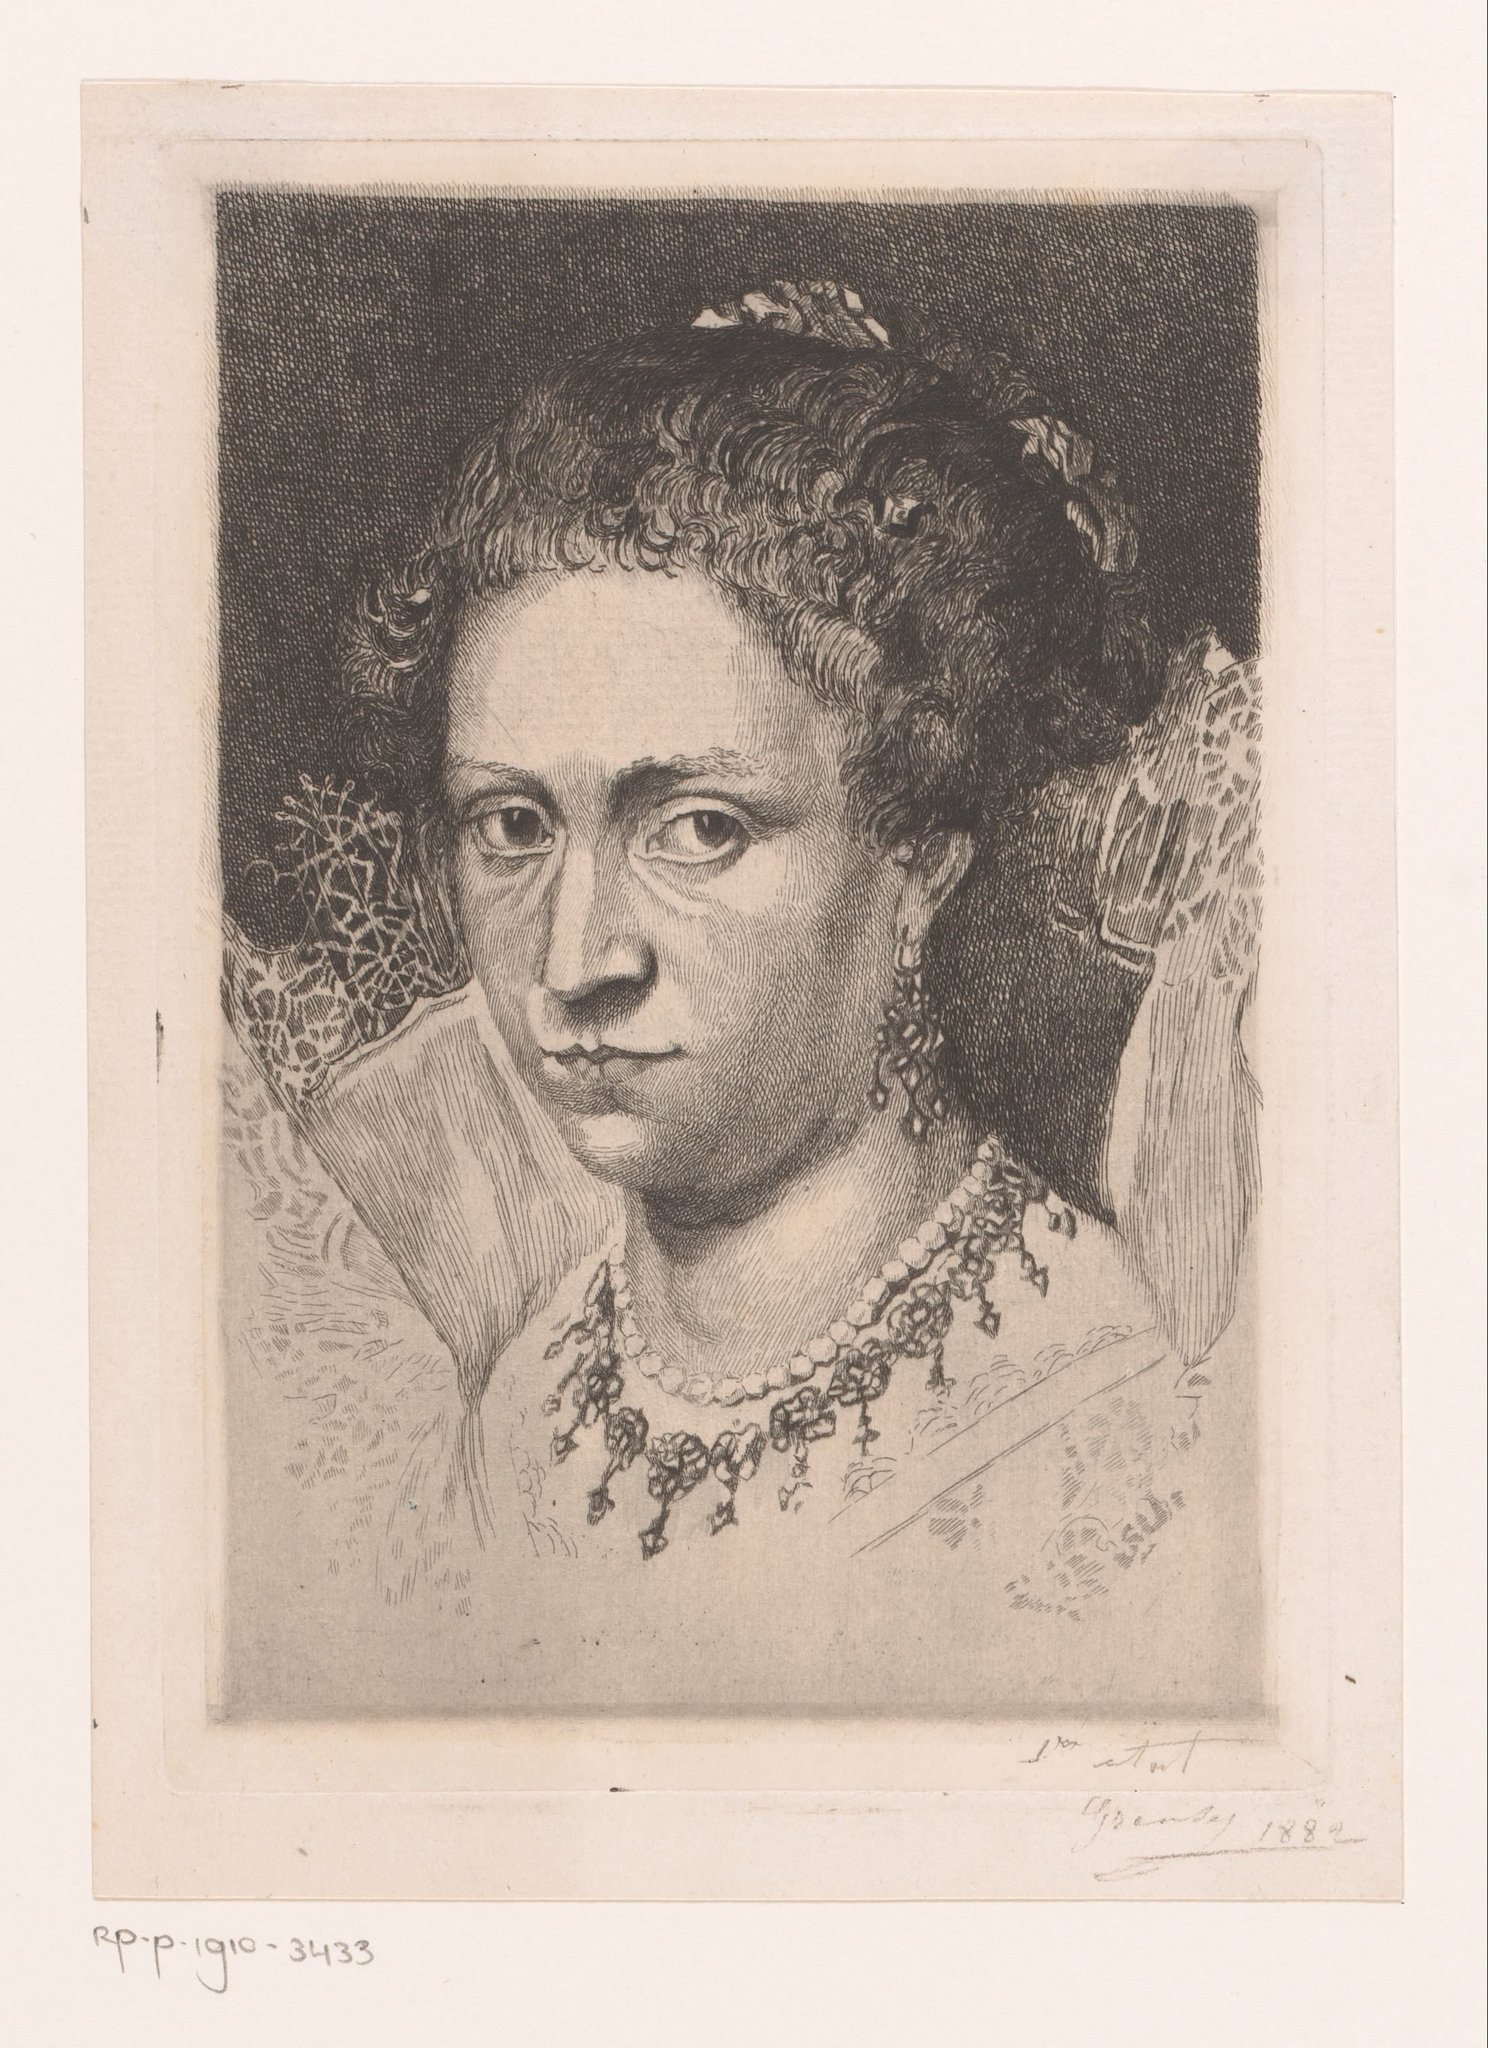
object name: print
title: Portret van Jacqueline de Caestre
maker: louis joseph greuse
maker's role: print maker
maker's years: 1863-1950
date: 1882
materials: paper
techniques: etching, intaglio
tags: historical persons - bb - woman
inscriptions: annotation: ‘1m etat’, collector's mark: Lugt 2228